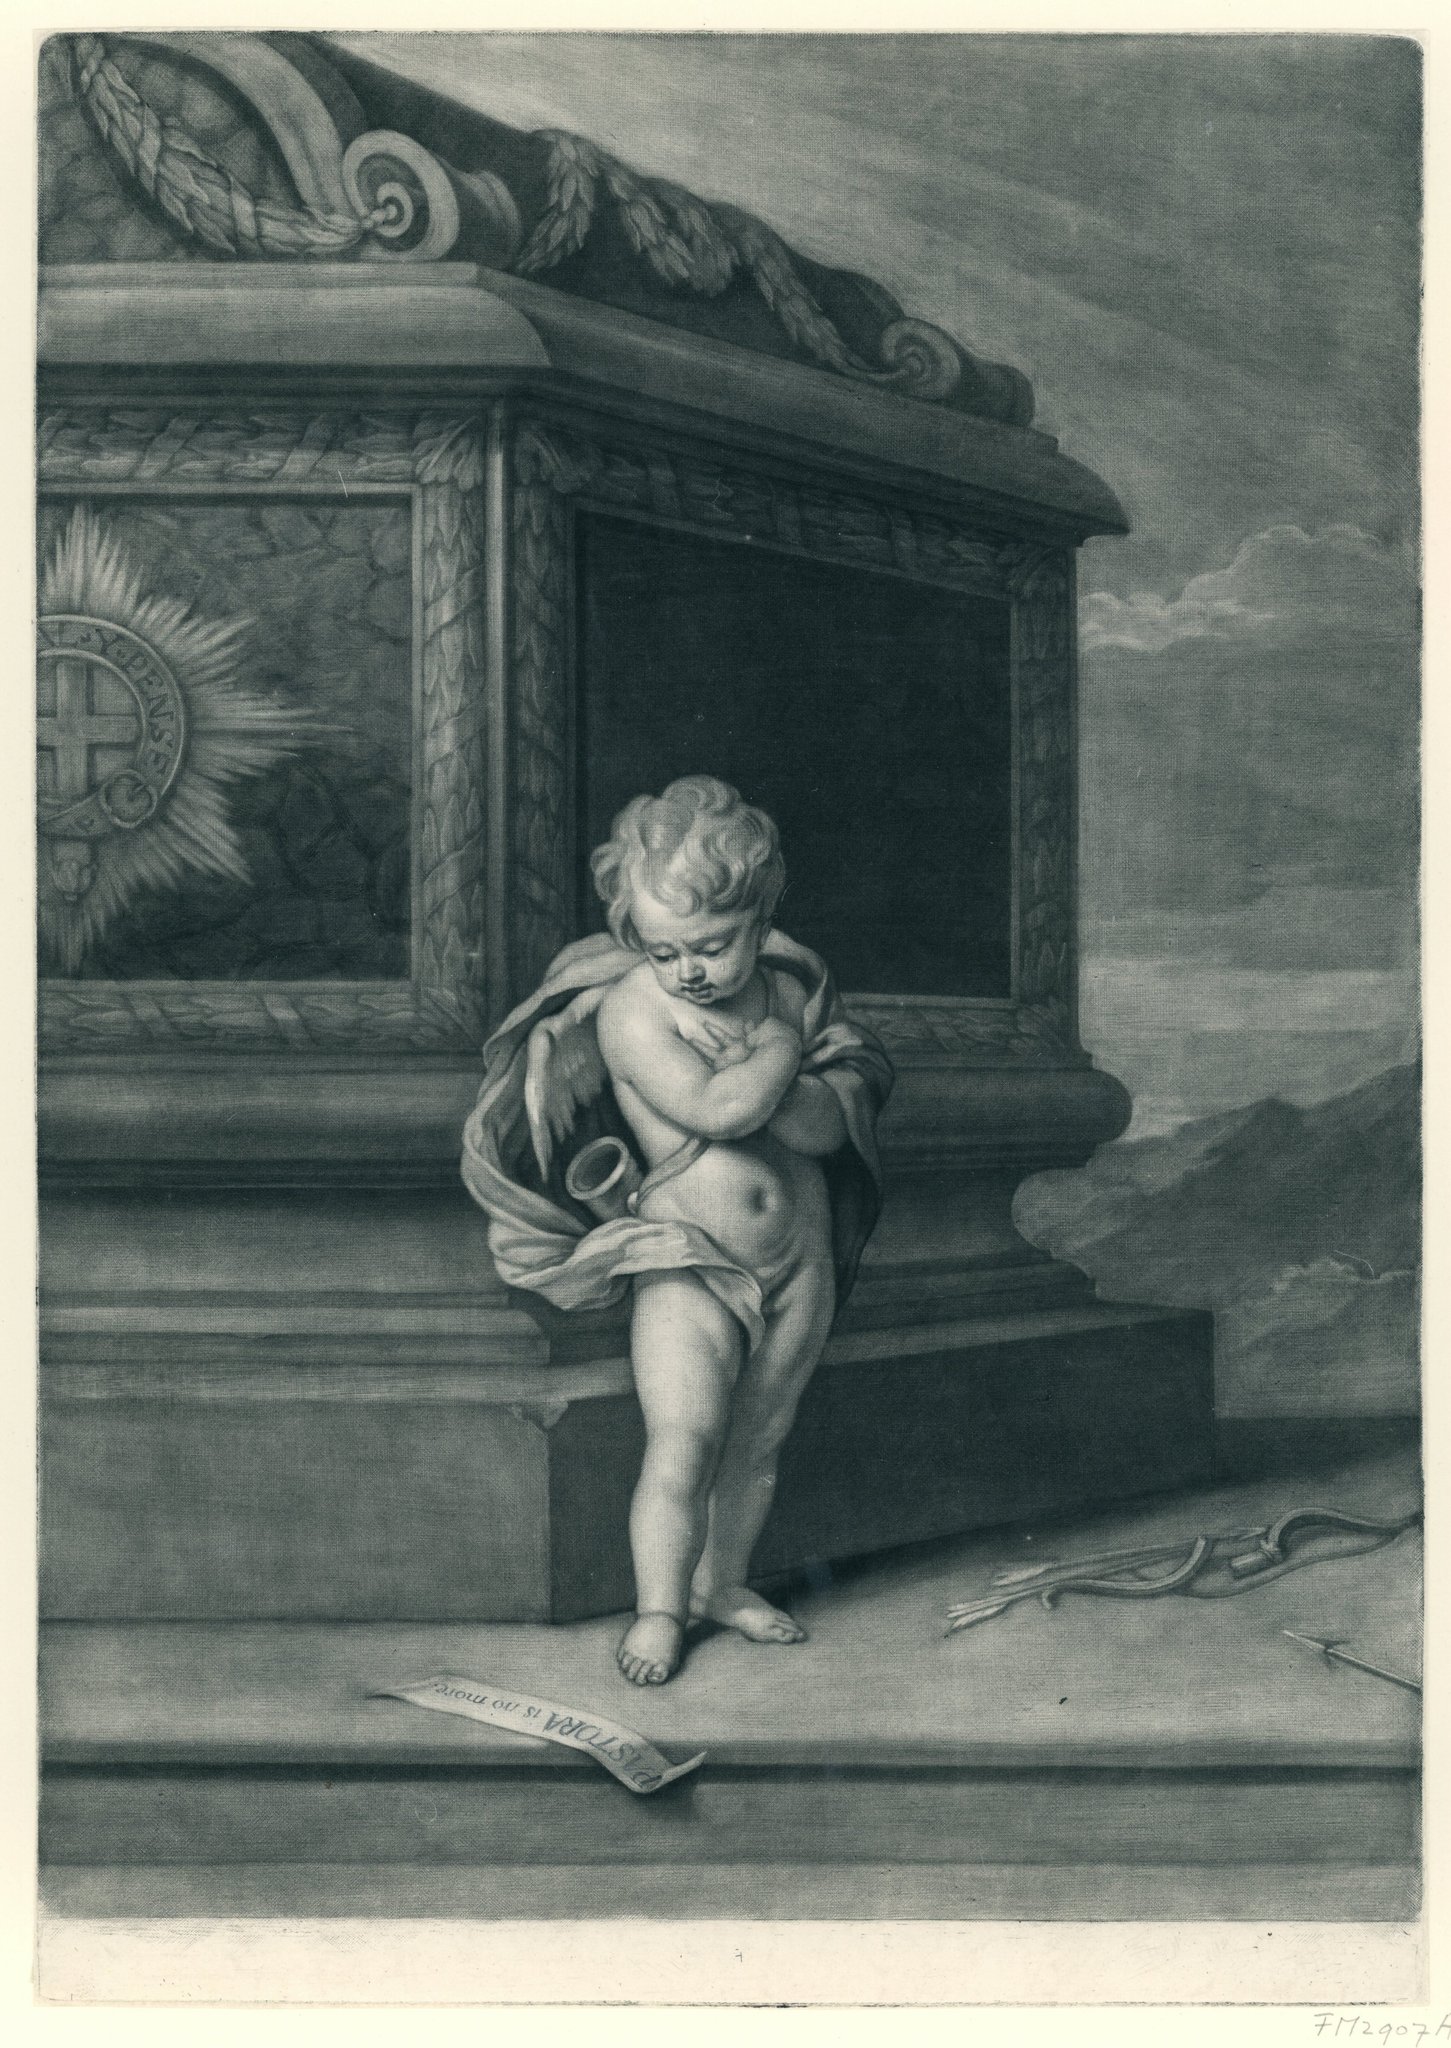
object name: print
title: Zinneprent ter nagedachtenis aan Maria Stuart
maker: john smith (prentmaker/ uitgever)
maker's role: print maker, publisher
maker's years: 1652-1743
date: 1695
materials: paper, pencil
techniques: mezzotint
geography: england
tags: london, maria ii stuart (koningin van engeland, schotland en ierland), specific aspects of cupid, mourning the dead, grave-building, monumental tomb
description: Allegorische voorstelling vervaardigd ter nagedachtenis aan Maria II Stuart, overleden op 7 januari 1695. Een treurende Cupido staat bij het graf van de koningin. Met een Latijns onderschrift onder de prent en de naam op de graftombe. Staat vóór de namen van de vervaardigers, het onderschrift en de naam op de graftombe. Op het strookje papier dat op de grond ligt is met potlood geschreven 'PASTORA is no more'.